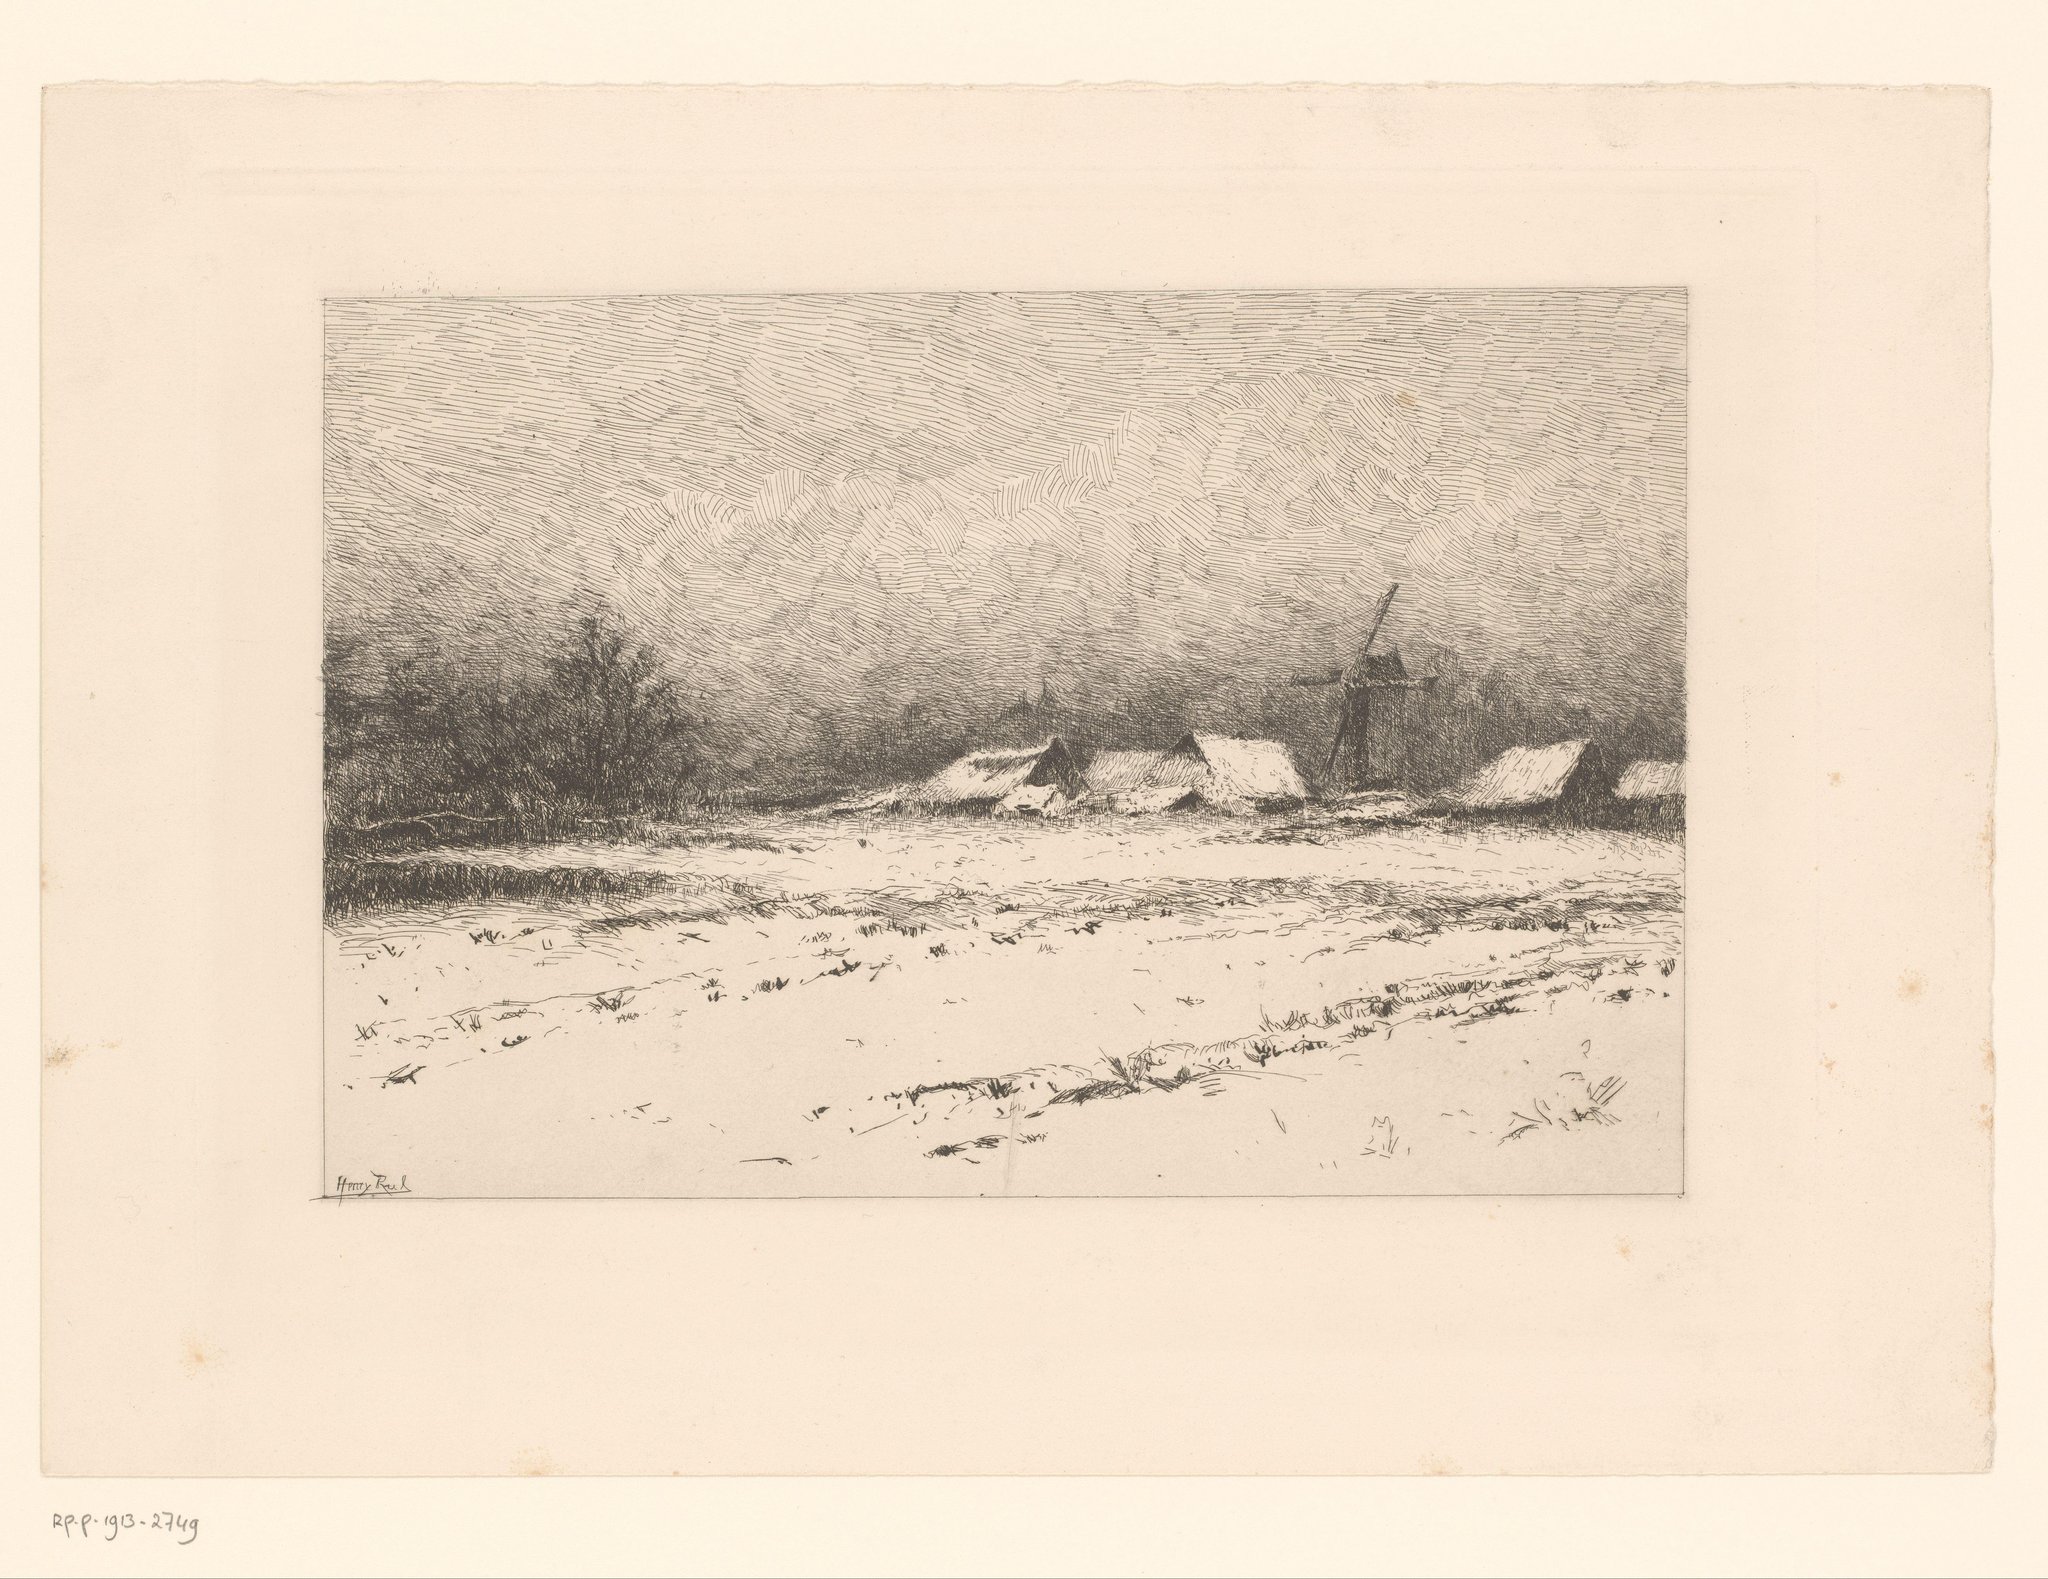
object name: print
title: Winterlandschap met molen en huizen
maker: henri rul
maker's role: print maker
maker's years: 1862-1942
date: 1872-1913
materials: paper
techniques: etching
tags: village, winter landscape; landscape symbolizing winter (the four seasons of the year), windmill in landscape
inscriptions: collector's mark: Lugt 2228